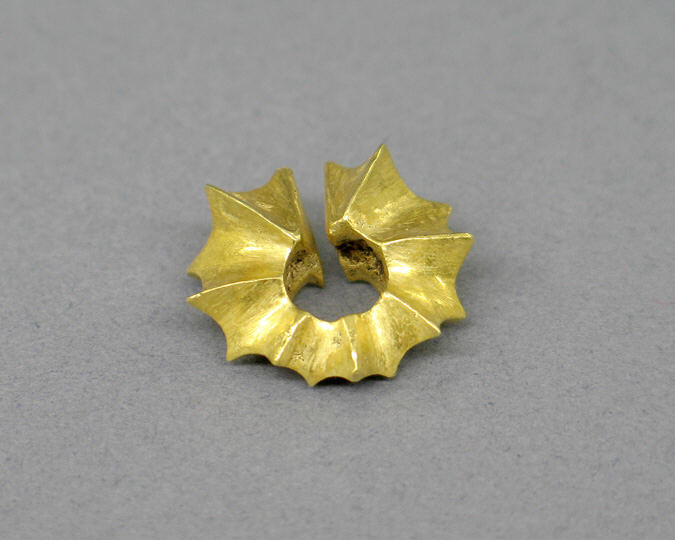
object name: ear clip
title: Ear Clip in the Shape of a Starfruit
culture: indonesian, javanese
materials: gold